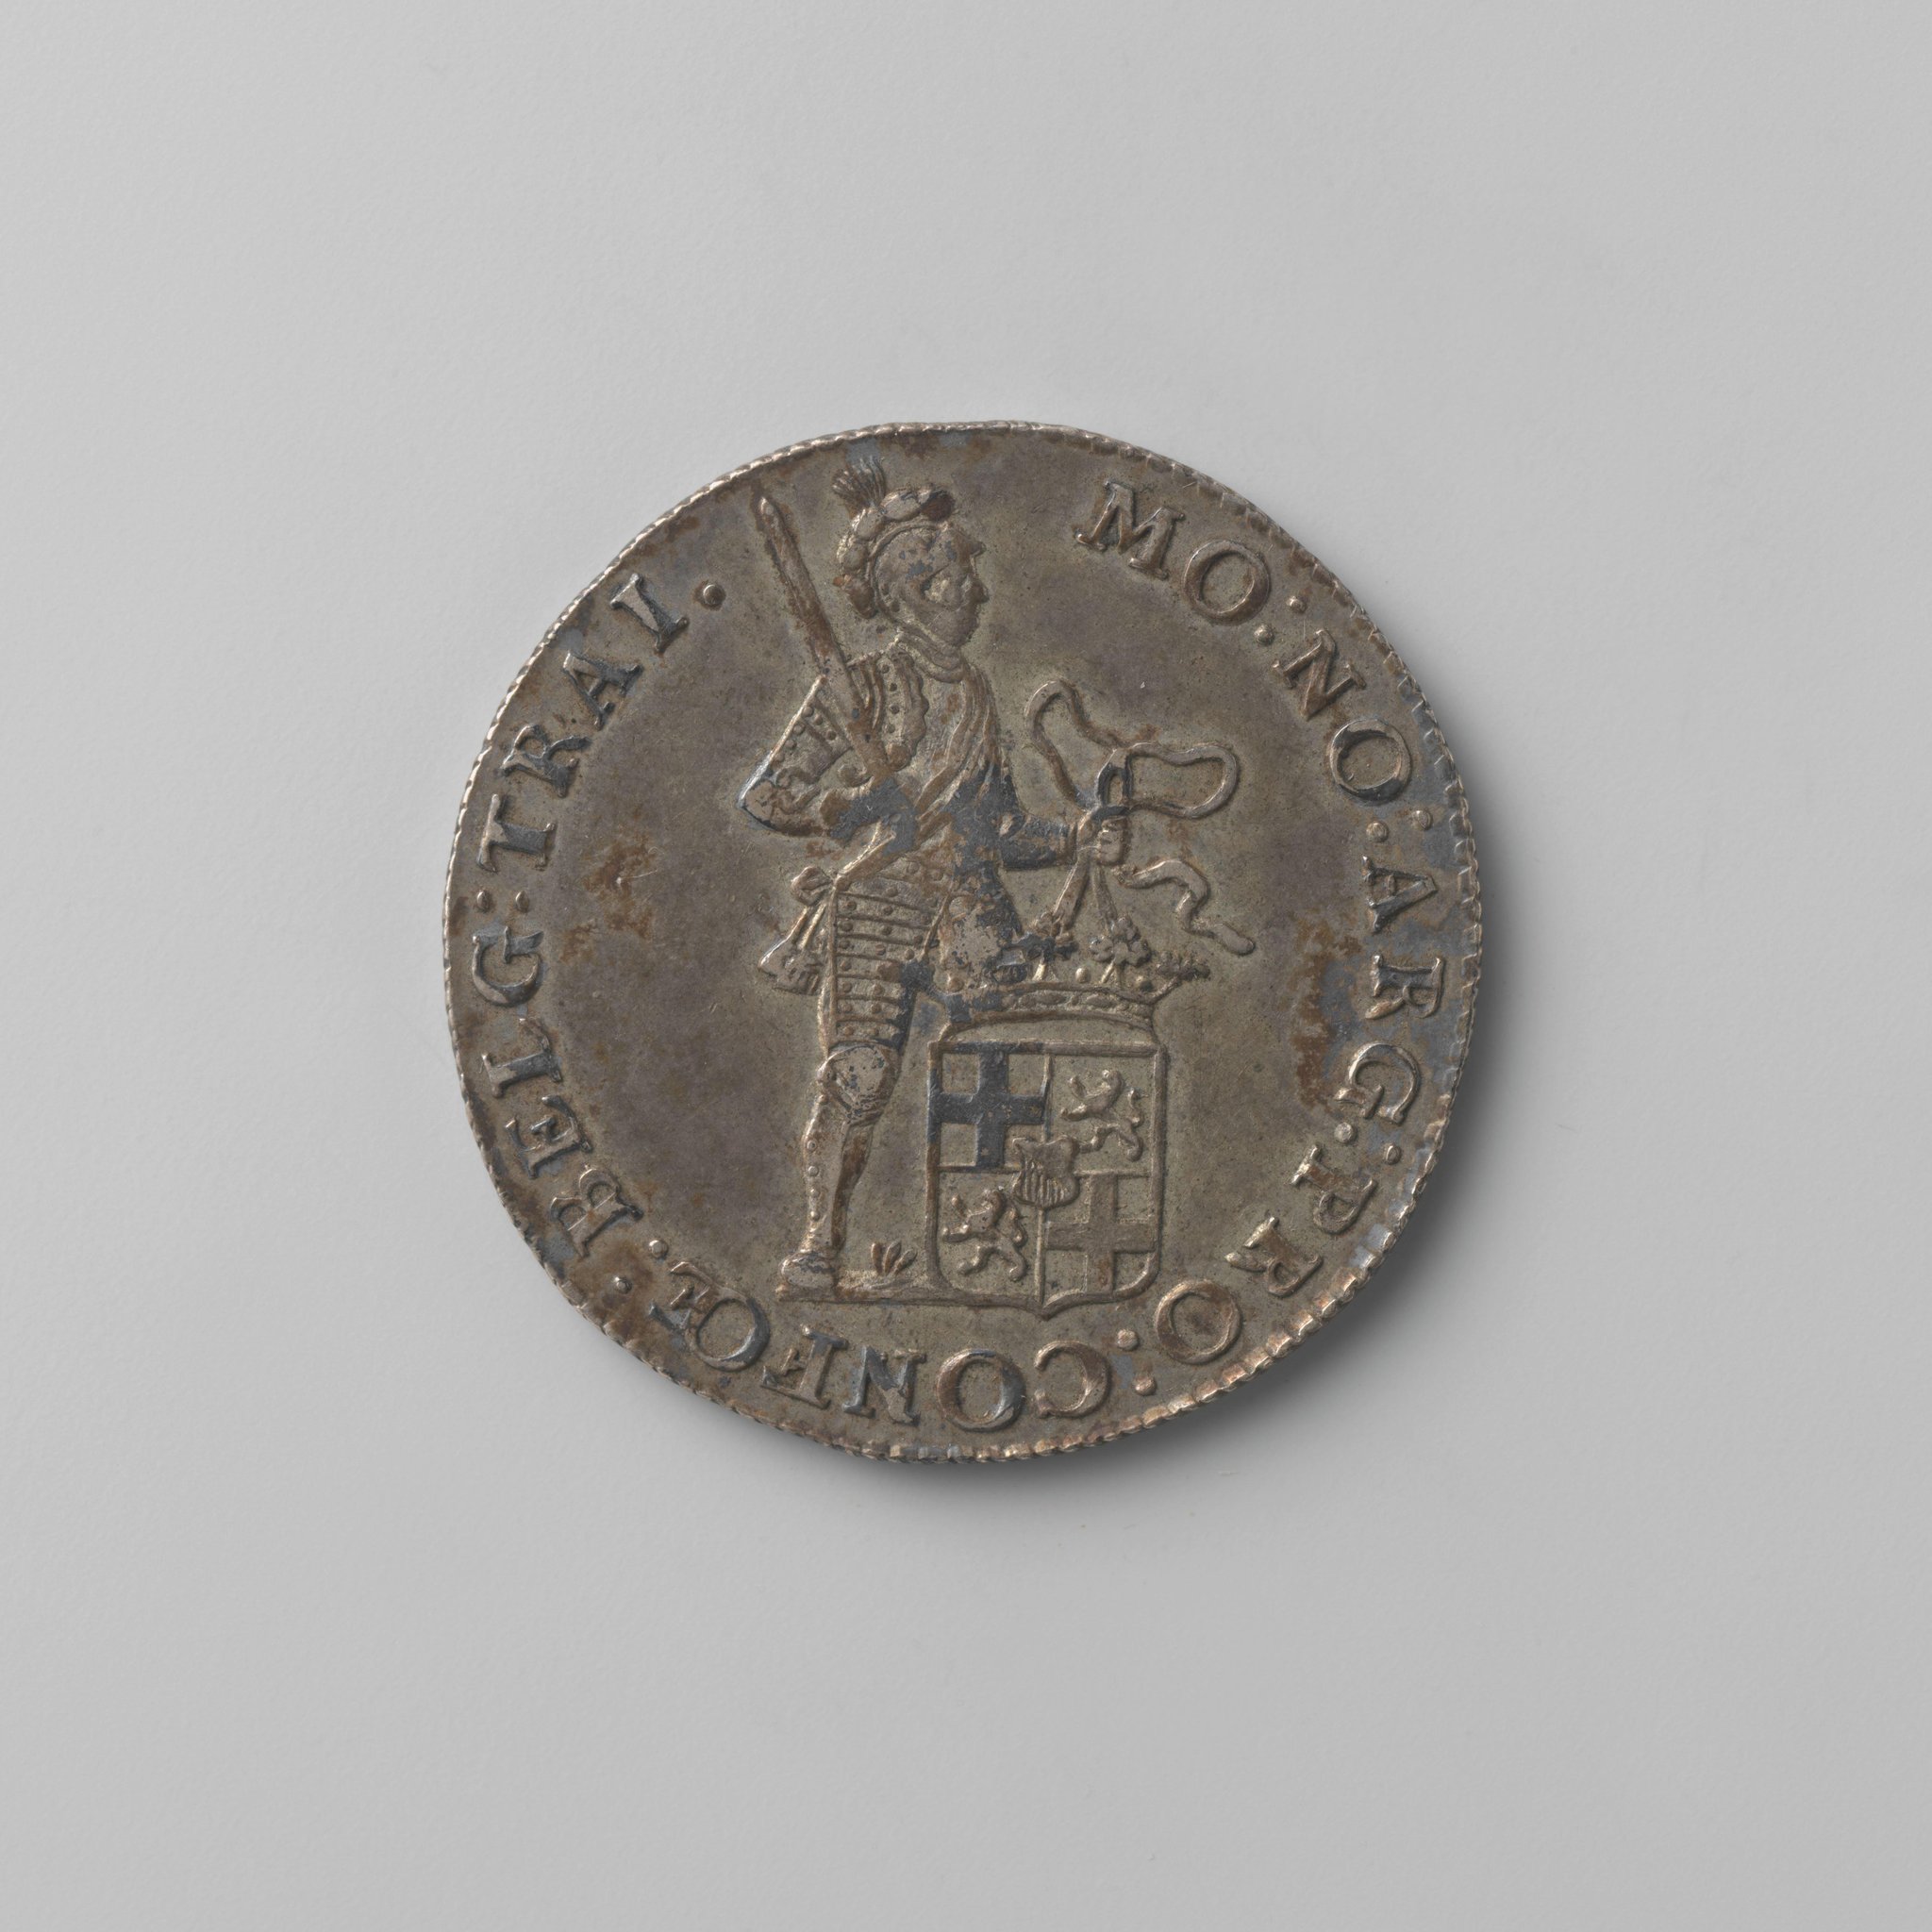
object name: coin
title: Utrechtse halve zilveren dukaat, 1764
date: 1764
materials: silver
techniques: striking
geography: utrecht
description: Zilveren munt. Voorzijde:staande geharnaste ridder naar rechts met zwaard in rechterhand en gekroond wapenschild van Utrecht aan lint in linkerhand. Keerzijde: tussen jaartal gekroond generaliteitswapenschild. Bloemrand.